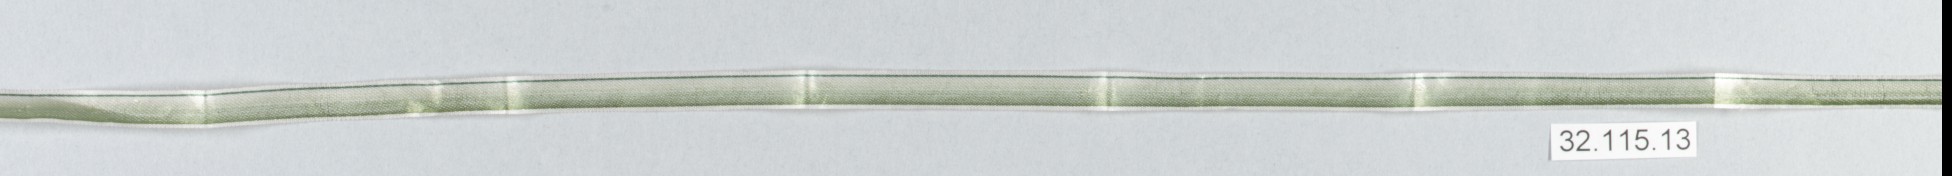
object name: ribbon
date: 1860